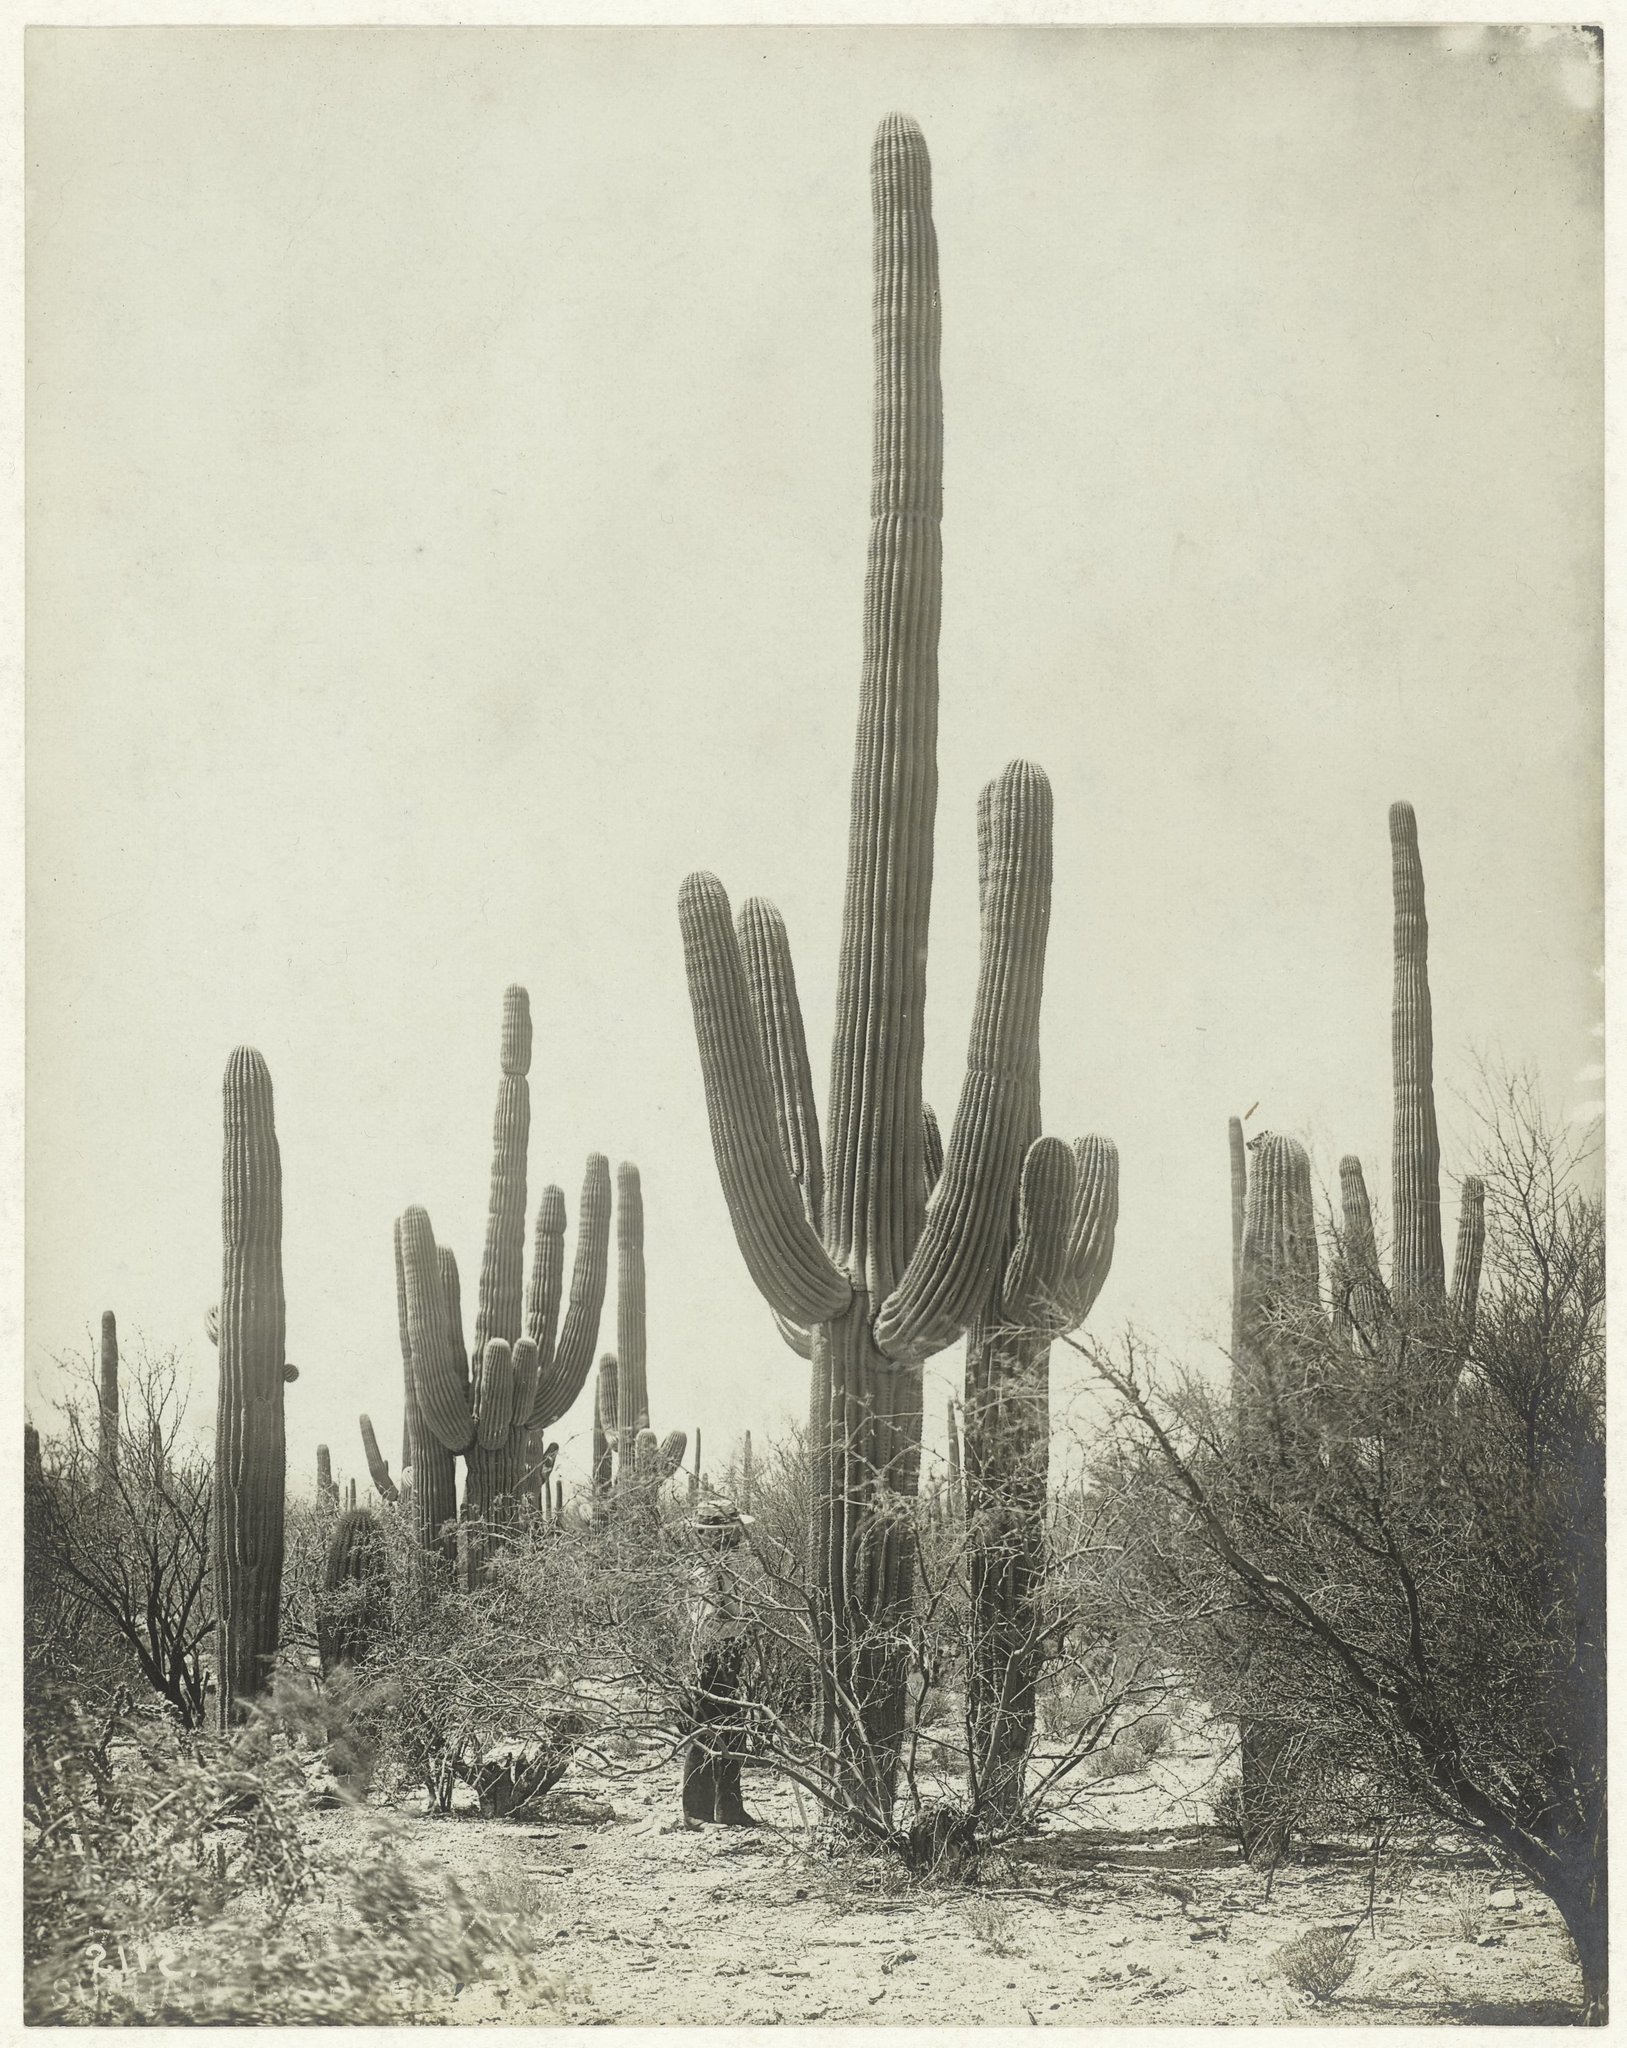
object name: photograph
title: Reuzencactus in de woestijn van Tuscon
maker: Anonymous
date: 1900-1920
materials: paper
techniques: gelatin silver print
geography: tucson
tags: landscapes in tropical and sub-tropical regions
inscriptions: inscription: ‘Tucson, Arizona/ Cereus Giganteus’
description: Ter indicatie van de schaal is er een man links naast de cactus afgebeeld.